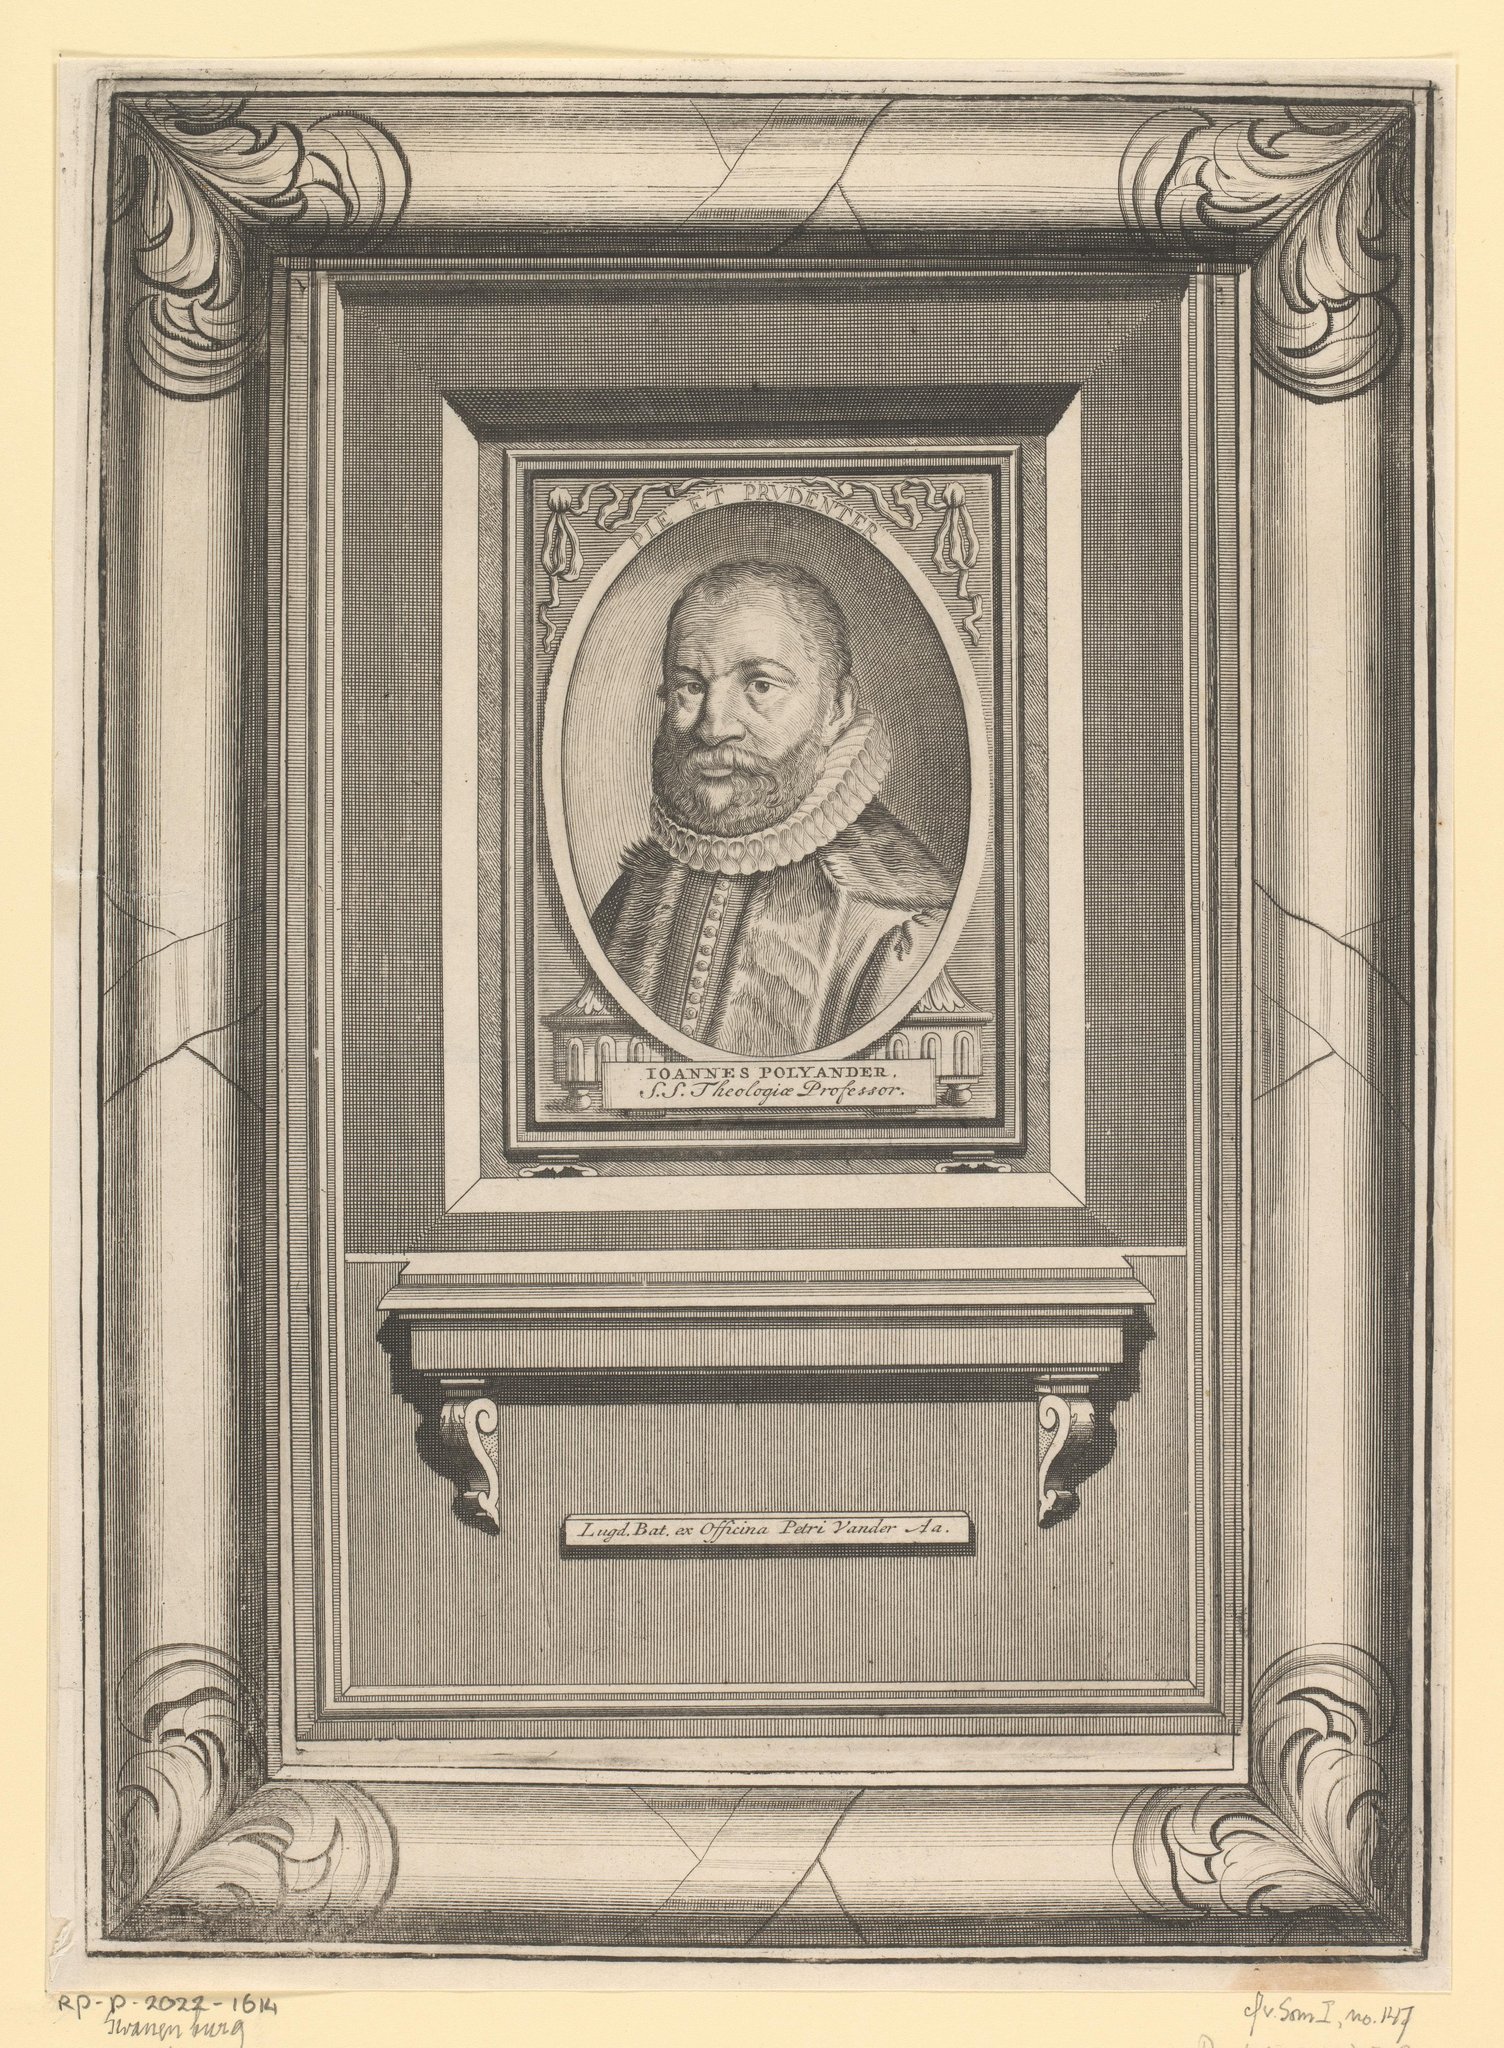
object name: print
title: Beroemde mannen aan de universiteit van Leiden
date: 1716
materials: paper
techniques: engraving, etching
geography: leiden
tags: leiden, theologian, historical persons